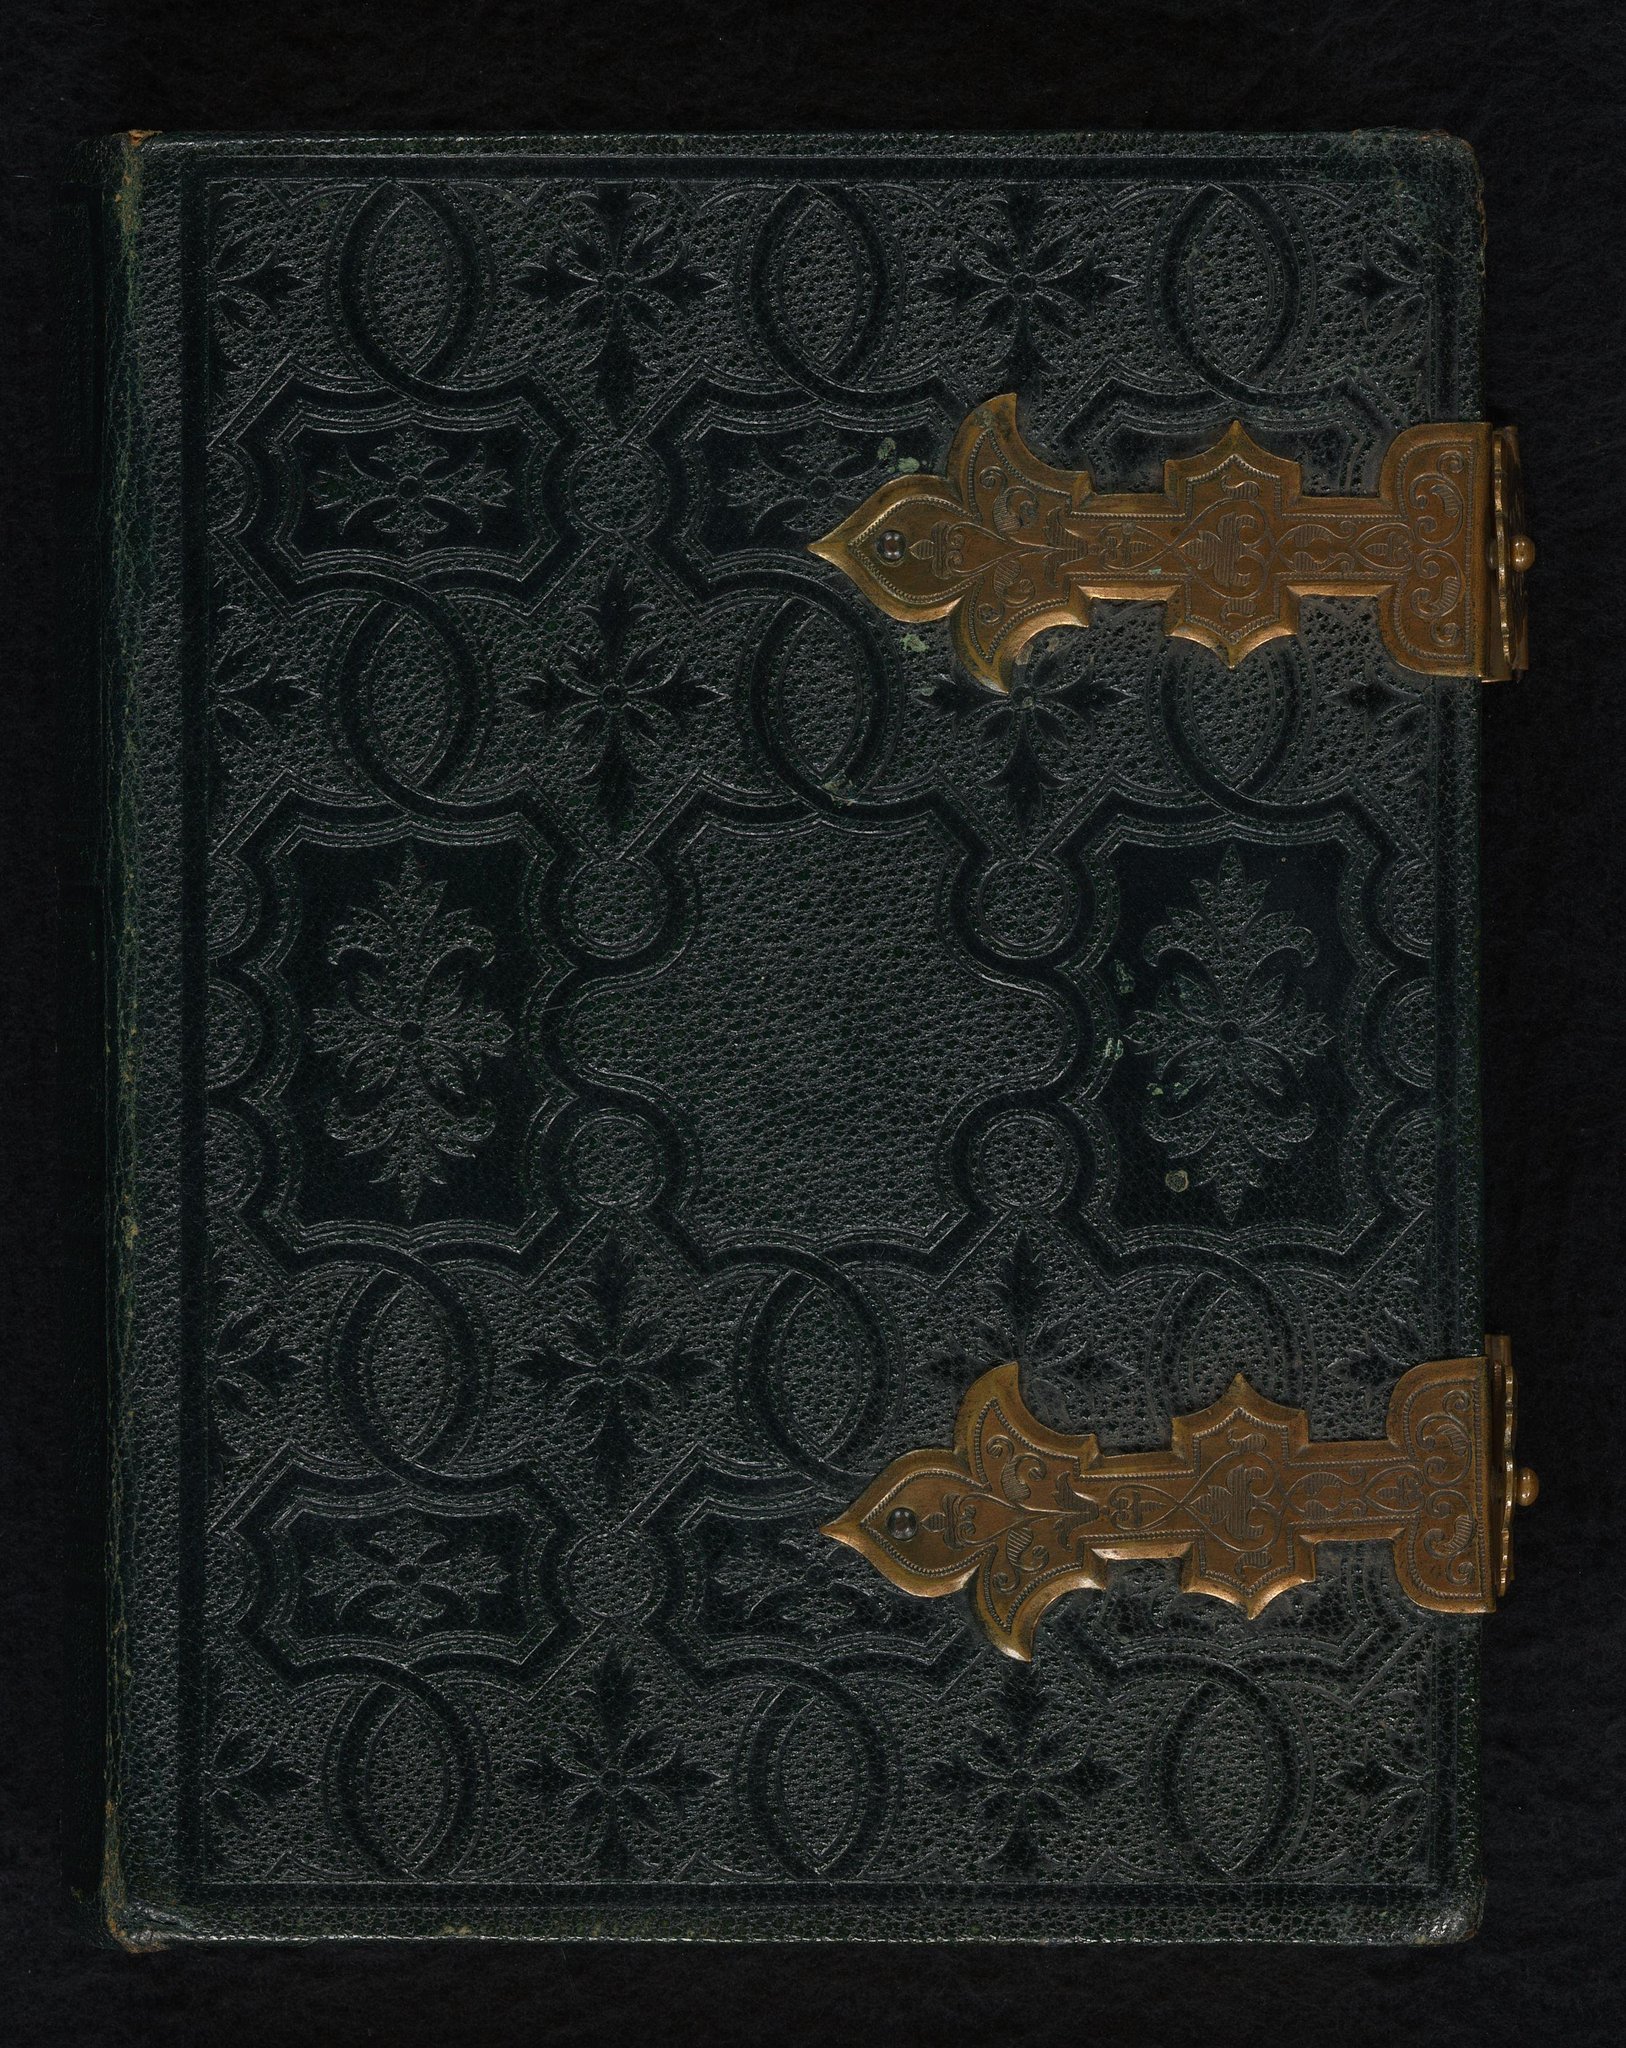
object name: photograph album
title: Fotoalbum met een portret van een soldaat en genrestukken met 23 foto's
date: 1860-1917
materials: cardboard, leather, metal, photographic support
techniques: albumen print, hand coloring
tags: adult man, historical persons, interior of the house, mother and baby or young child, (military) uniforms, painting, drawing and the graphic arts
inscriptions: inscription: ‘Dienst Verspreide Rijkskollekties (...)’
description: Fotoalbum met 30 pagina's met in totaal 23 foto's, alle cartes-de-visite. Het album bevat één portret van een man in uniform en 22 fotoreproducties van genrestukken van onder andere Wilhelm von Kaulbach.